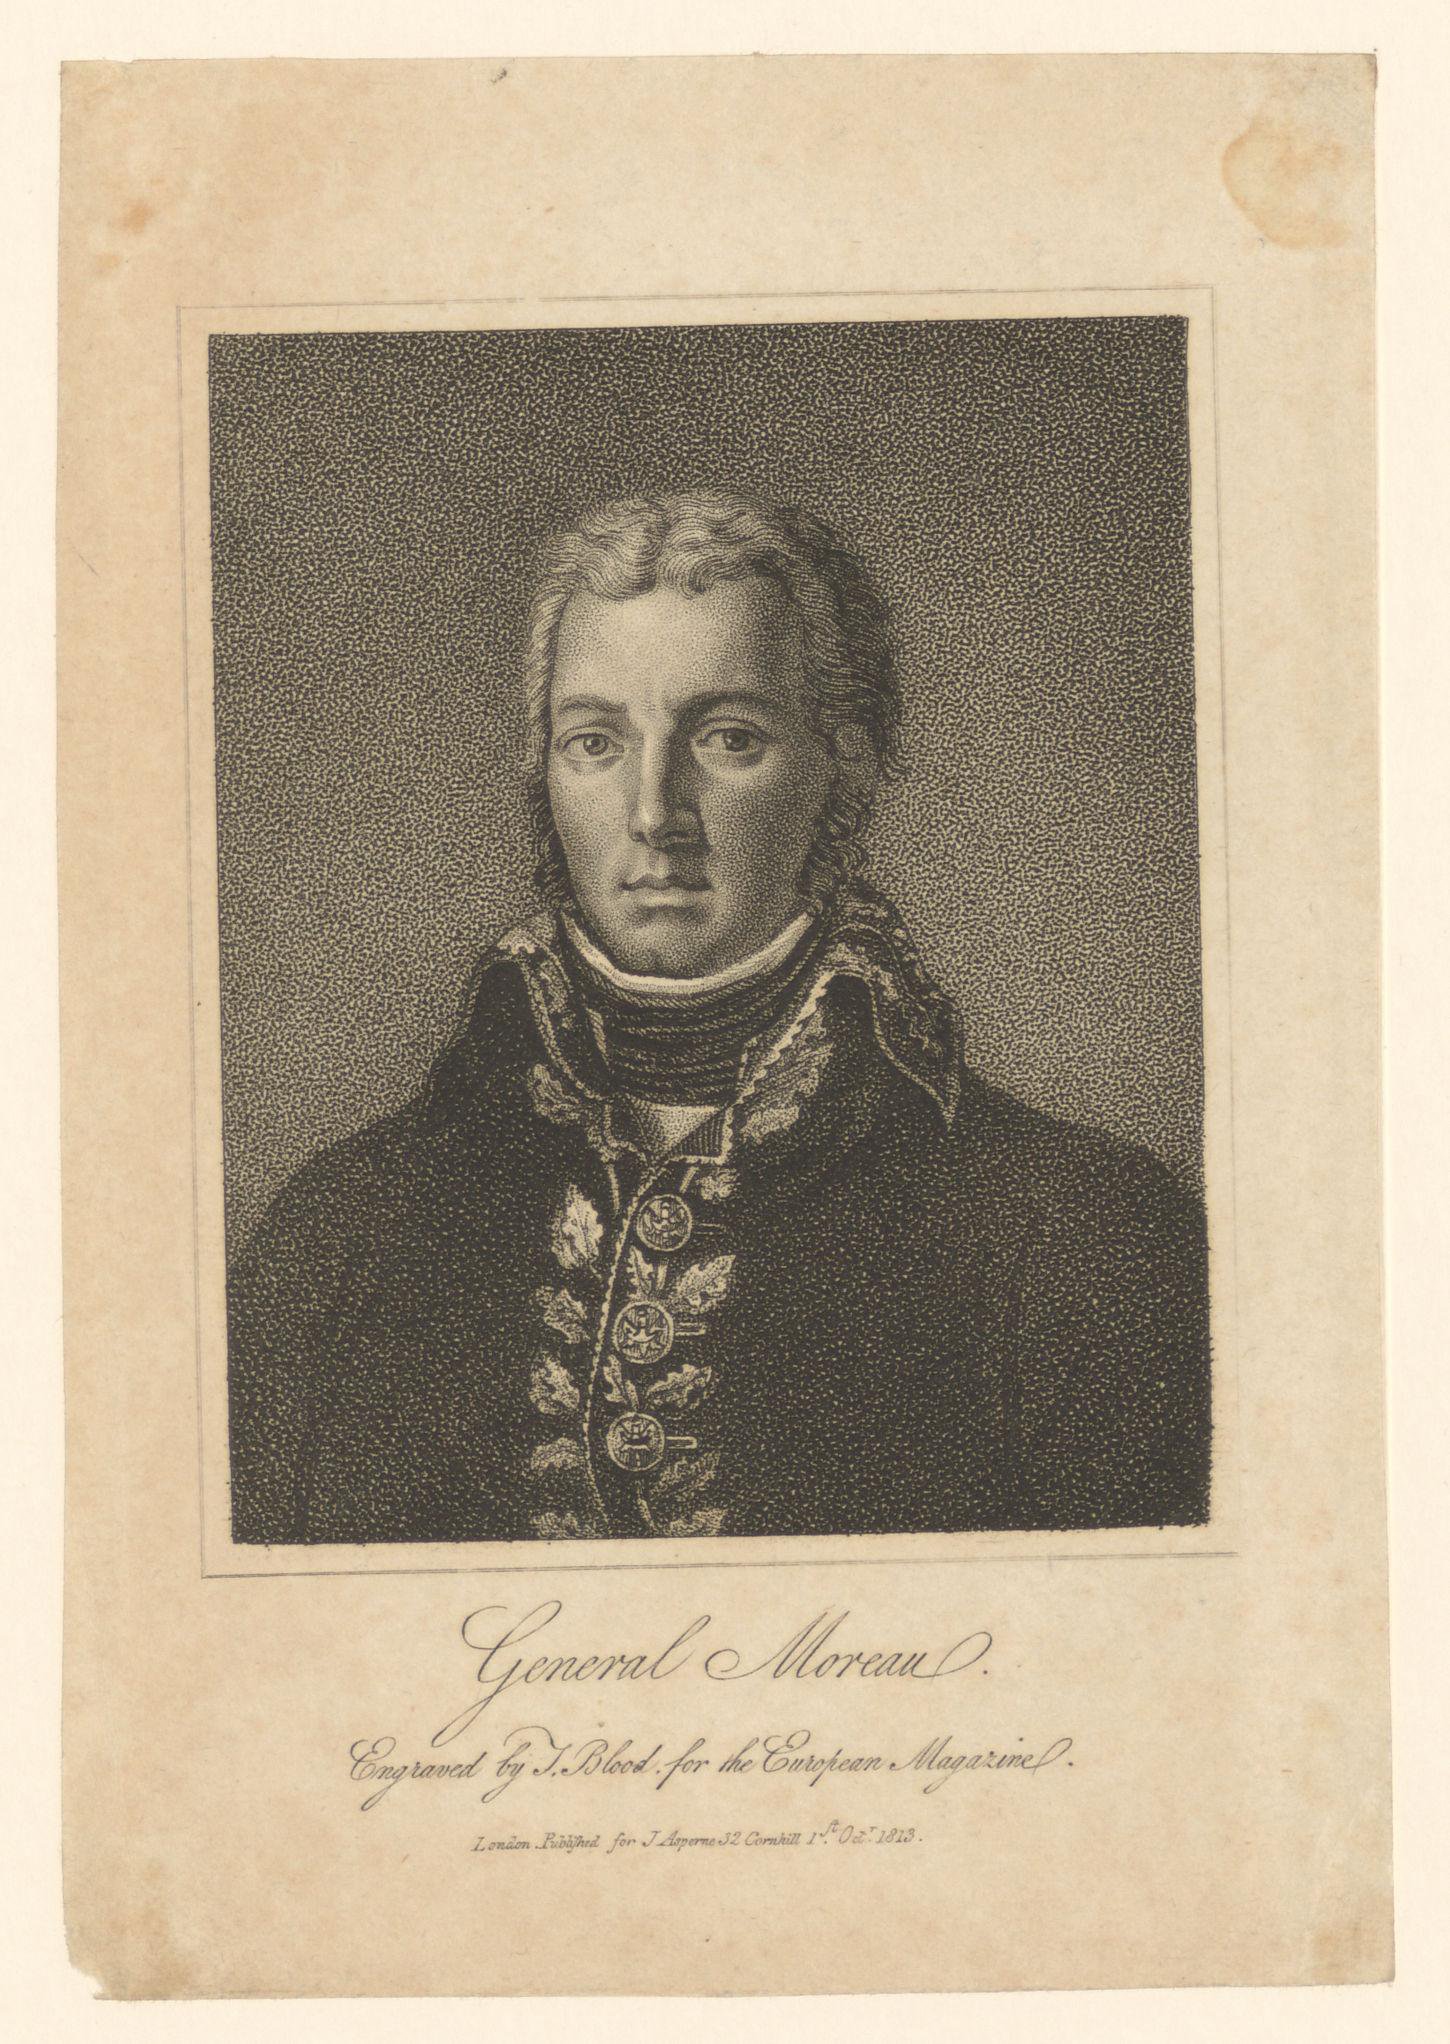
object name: print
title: General Moreau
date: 1810-1813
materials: paper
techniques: engraving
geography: london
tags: commander-in-chief, general, marshal, historical persons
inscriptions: collector's mark: Lugt 2228